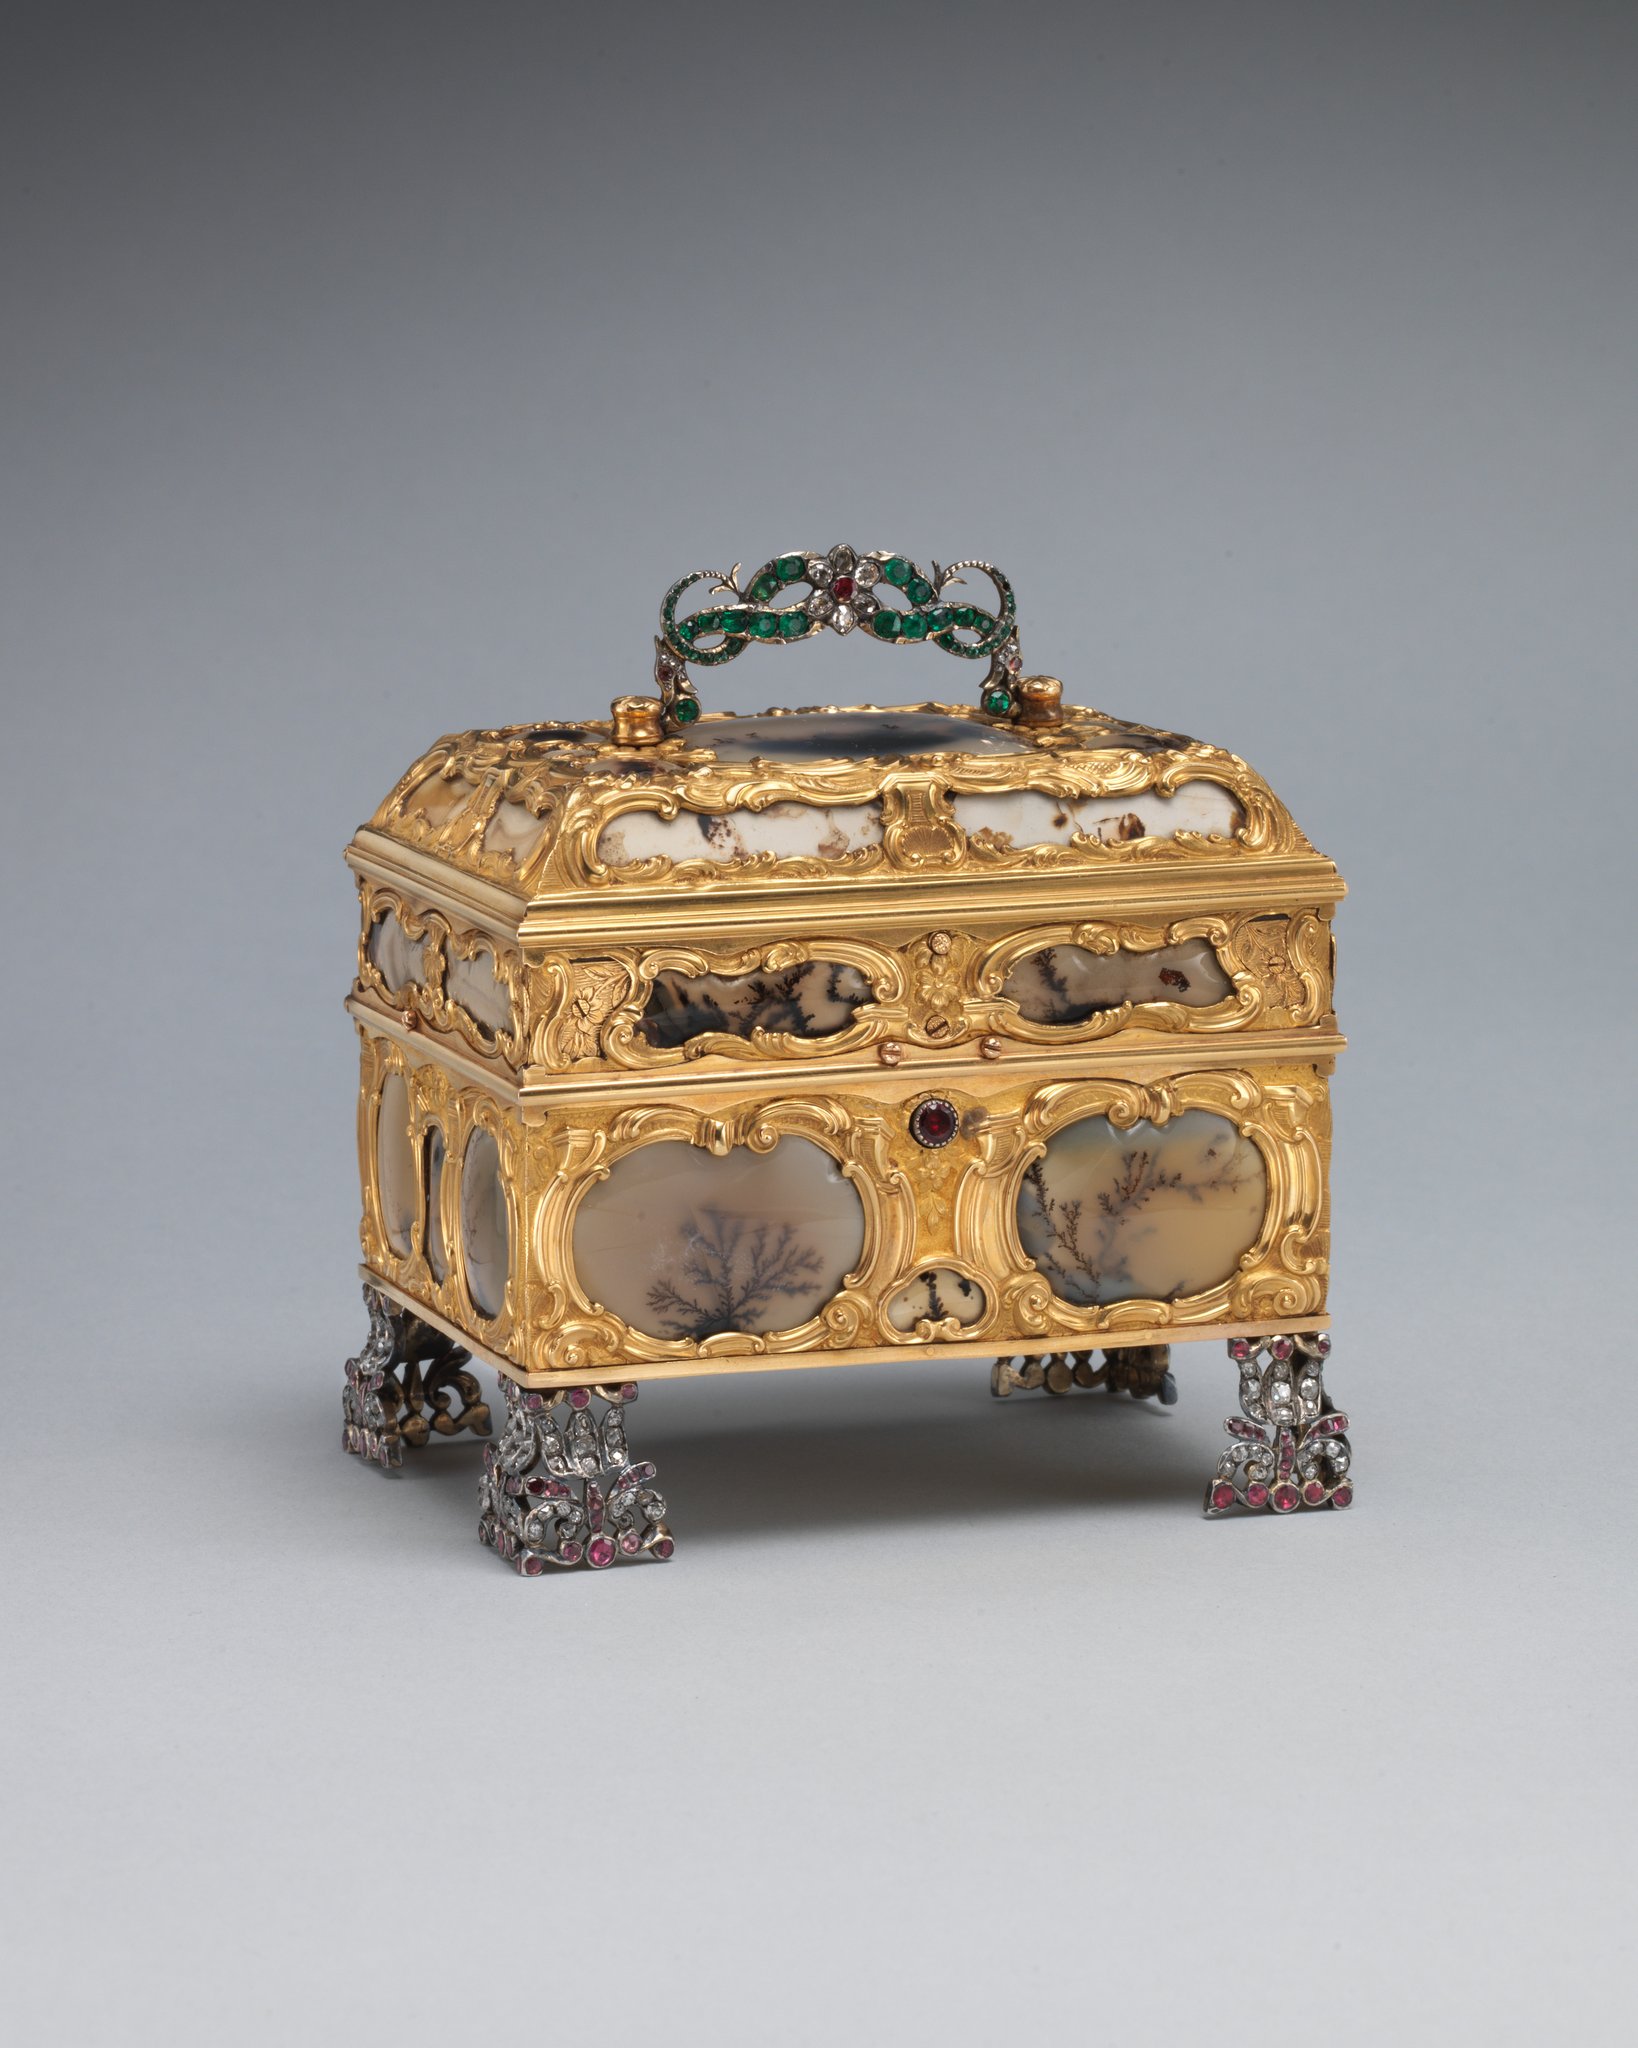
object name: nécessaire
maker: james cox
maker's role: maker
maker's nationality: british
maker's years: 1723-1800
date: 1770-1772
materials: stone, diamond, gemstone, enamel, gold, paste, silver